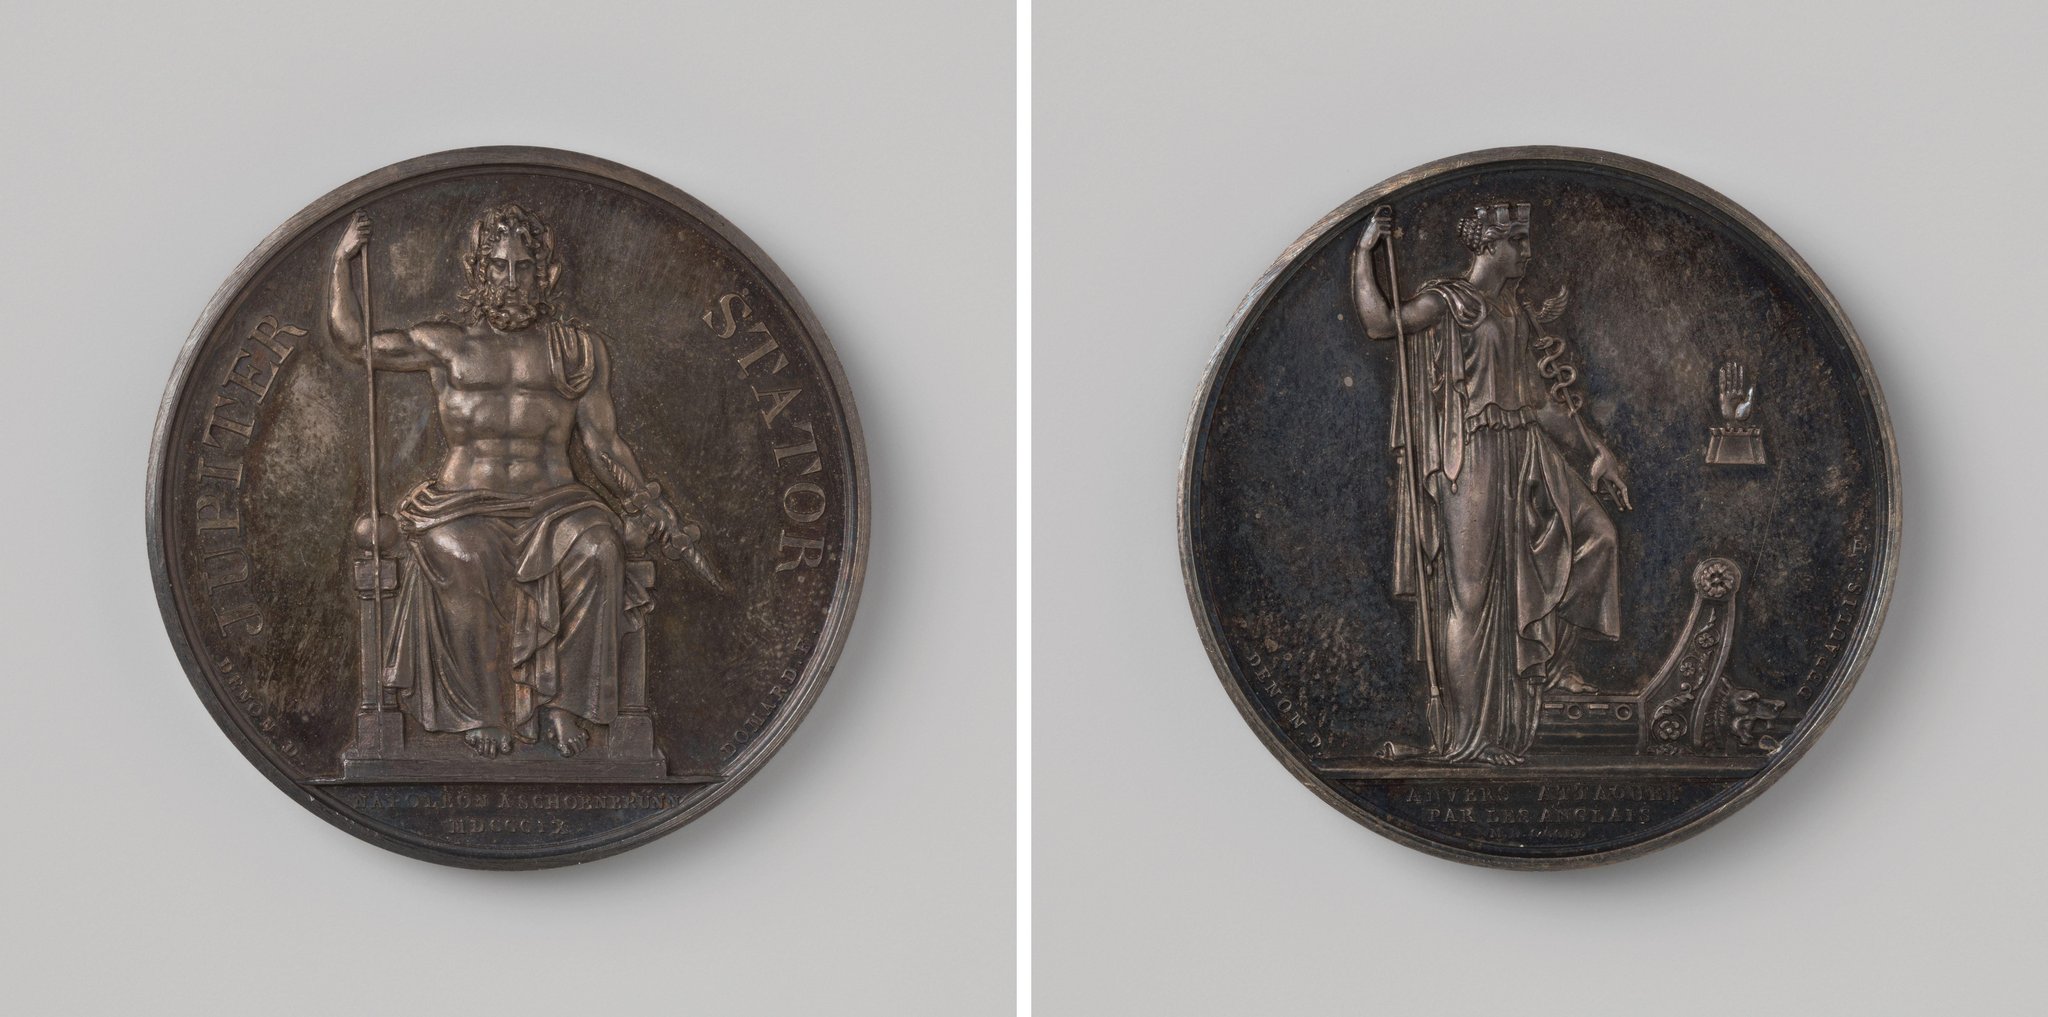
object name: history medal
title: Mislukte Engelse aanval op Antwerpen en vrede van Schonbrunn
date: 1809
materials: silver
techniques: striking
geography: paris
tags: napoleon i (emperor of the french)